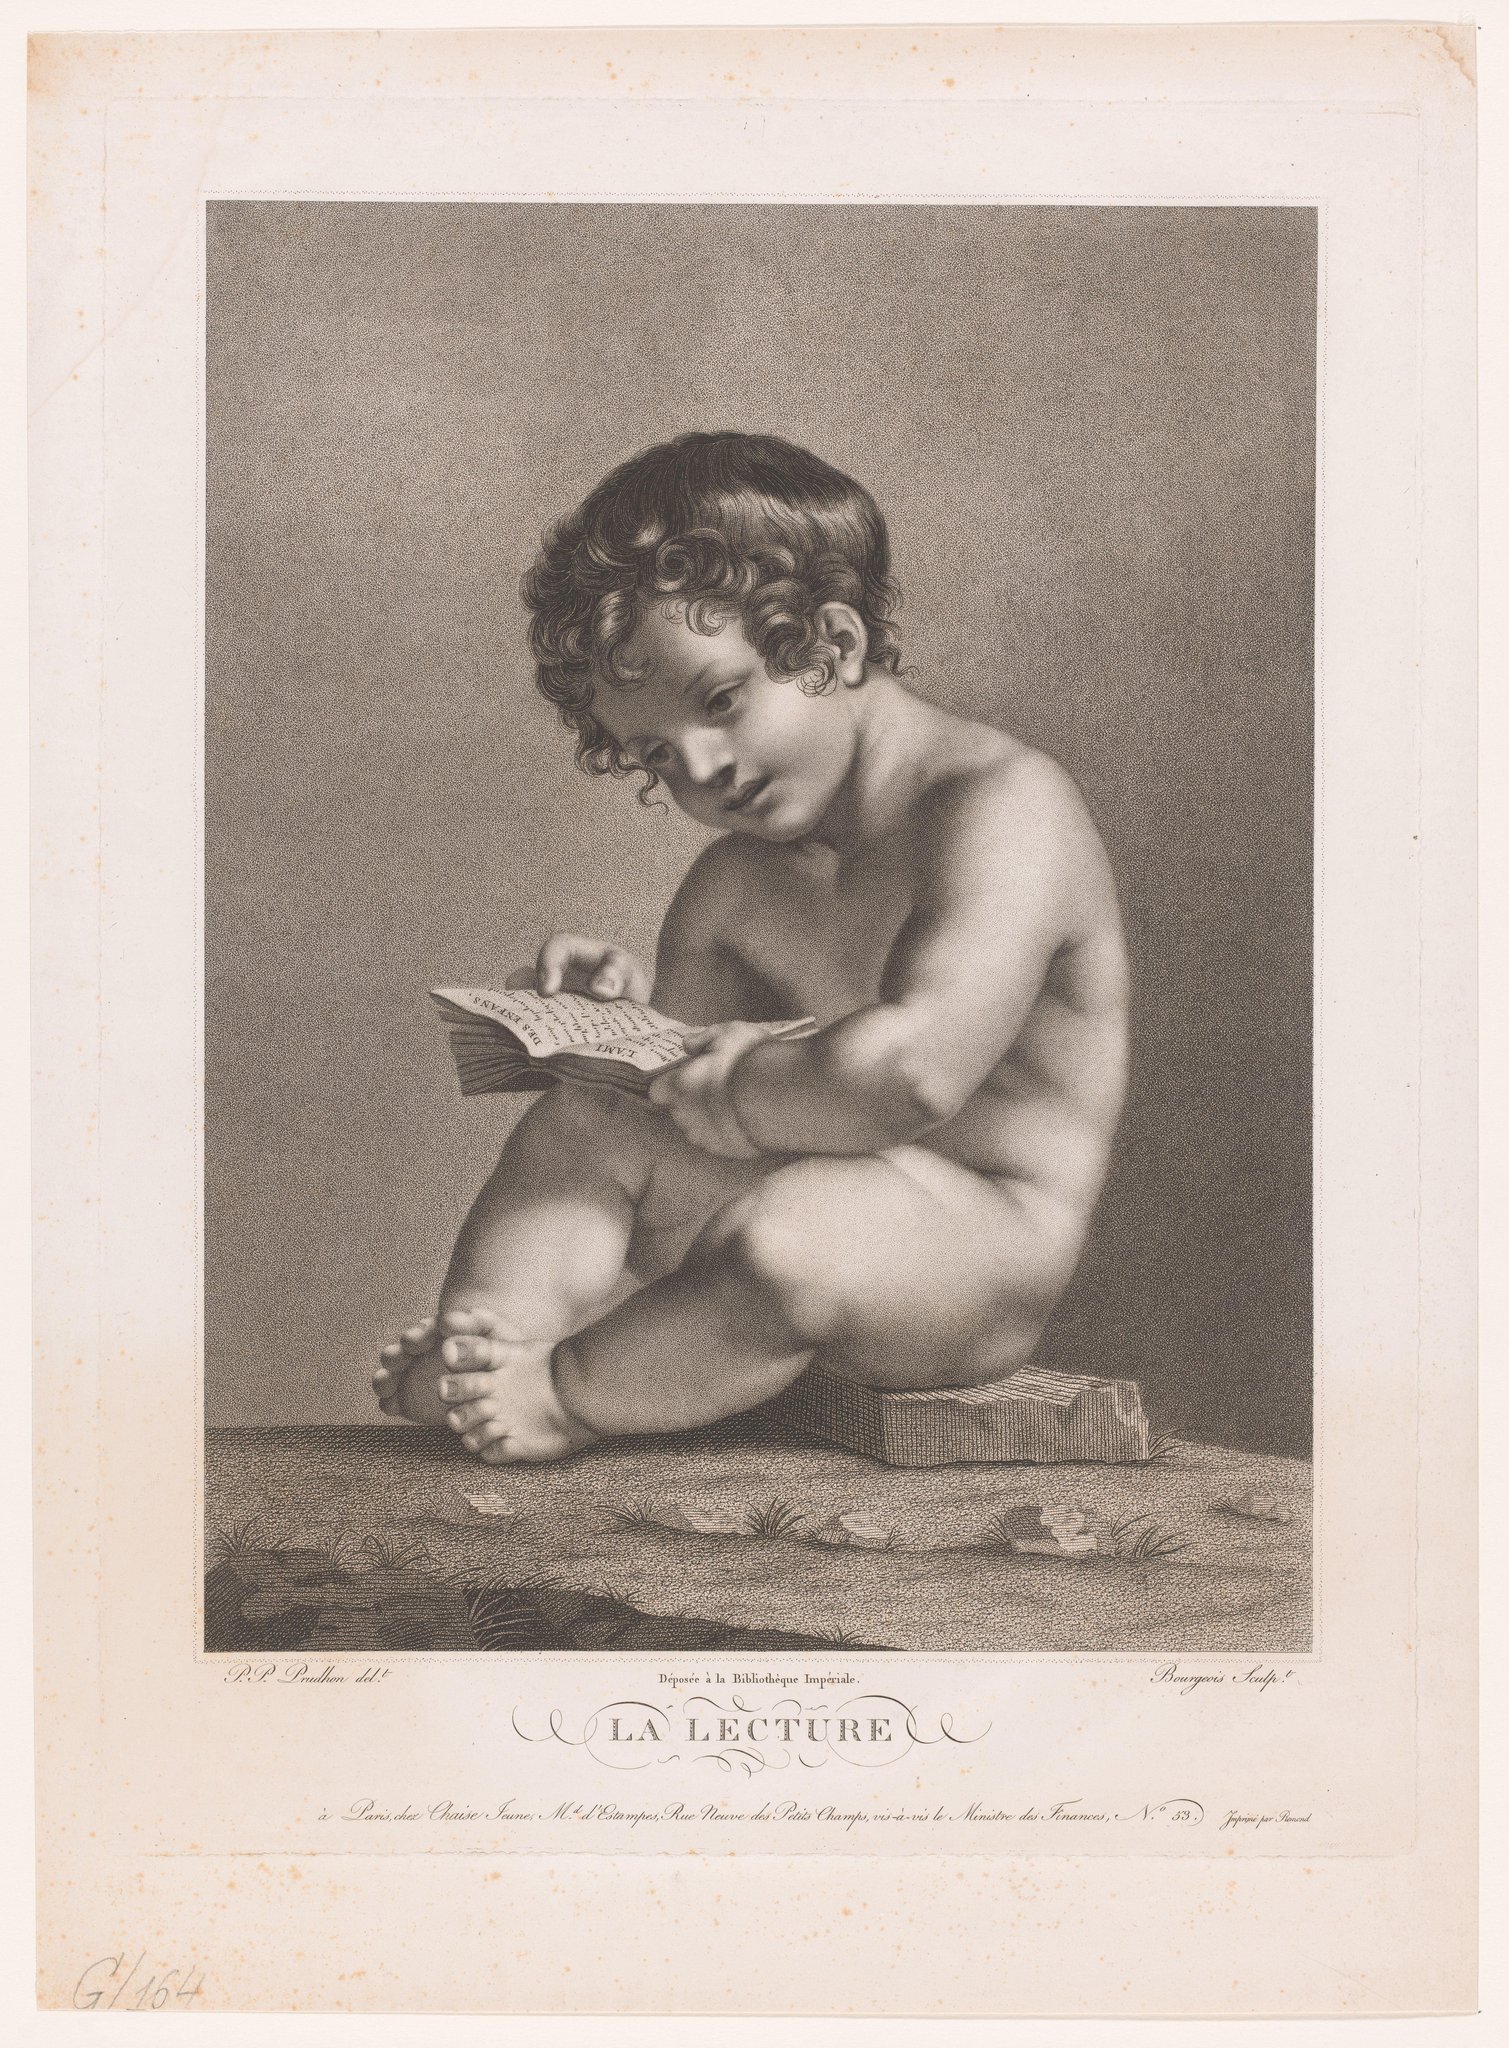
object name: print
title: Lezend kind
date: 1770-1825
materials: paper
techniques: etching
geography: paris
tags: reading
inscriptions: : ‘Déposé à la Bibliothèque Impériale’, collector's mark: Lugt 2228